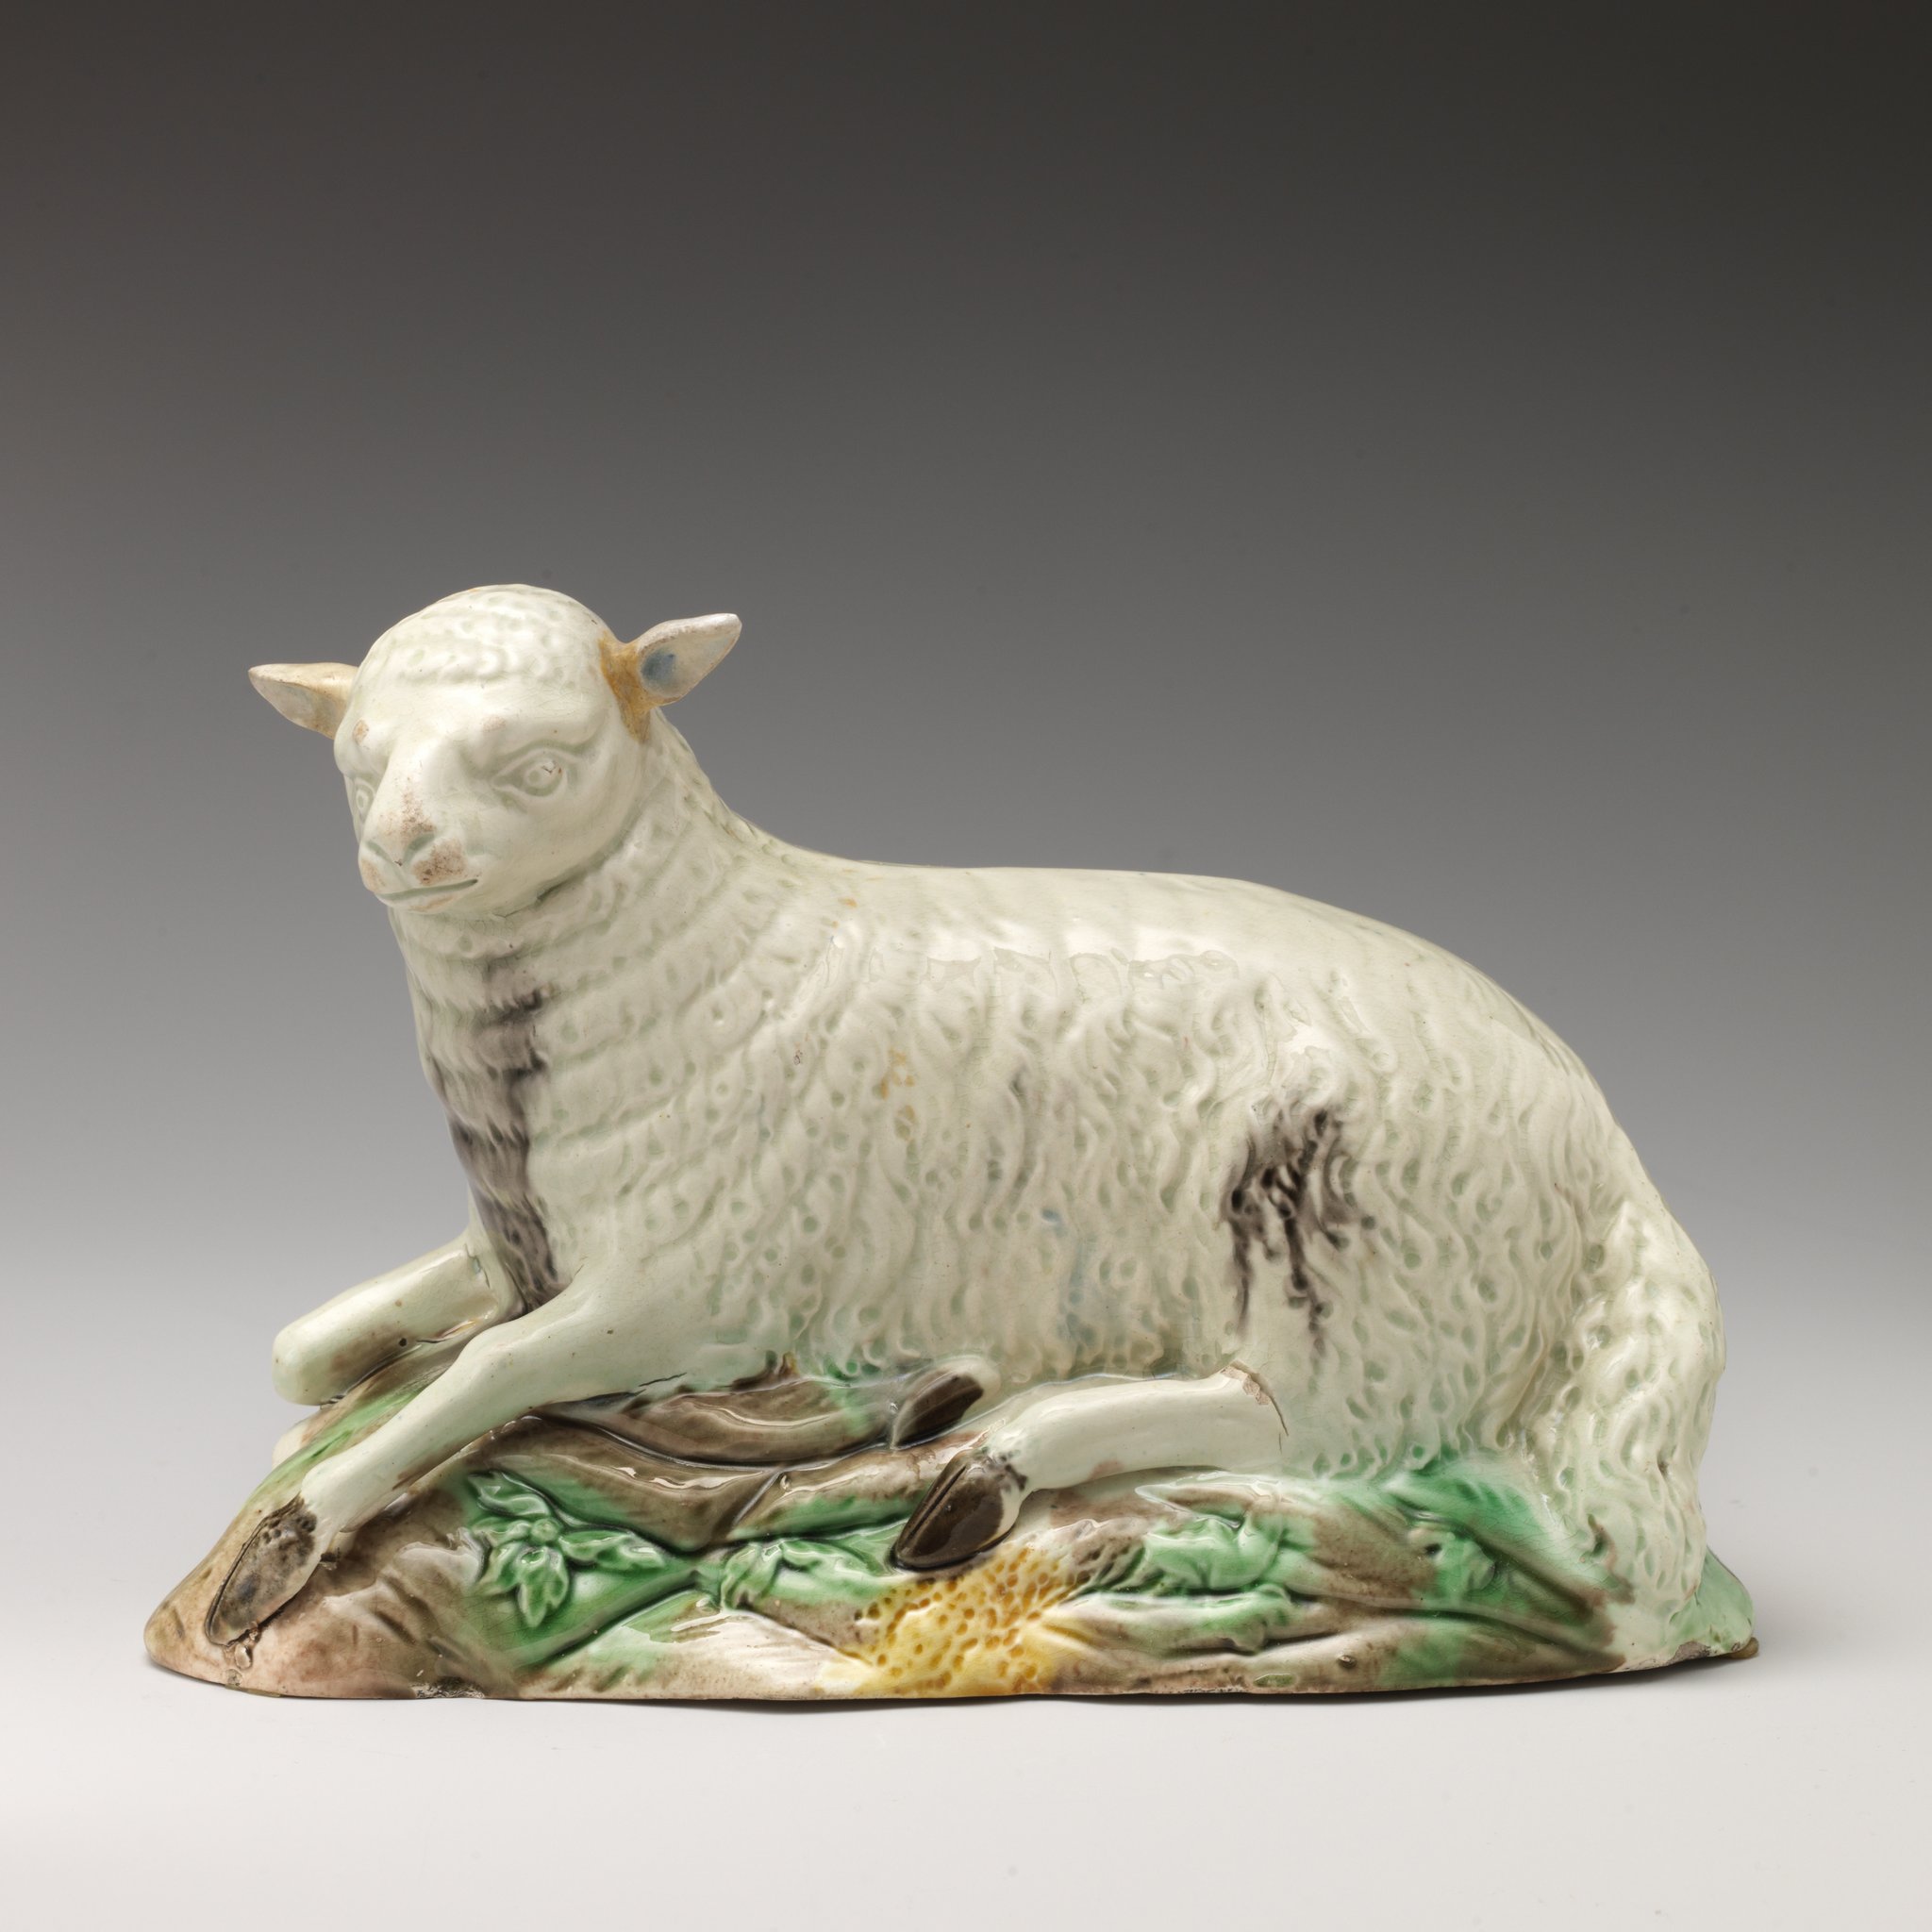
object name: figure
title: Sheep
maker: ralph wood the younger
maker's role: maker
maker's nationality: british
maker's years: 1748-1795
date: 1770-1780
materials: earthenware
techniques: glazing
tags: sheep